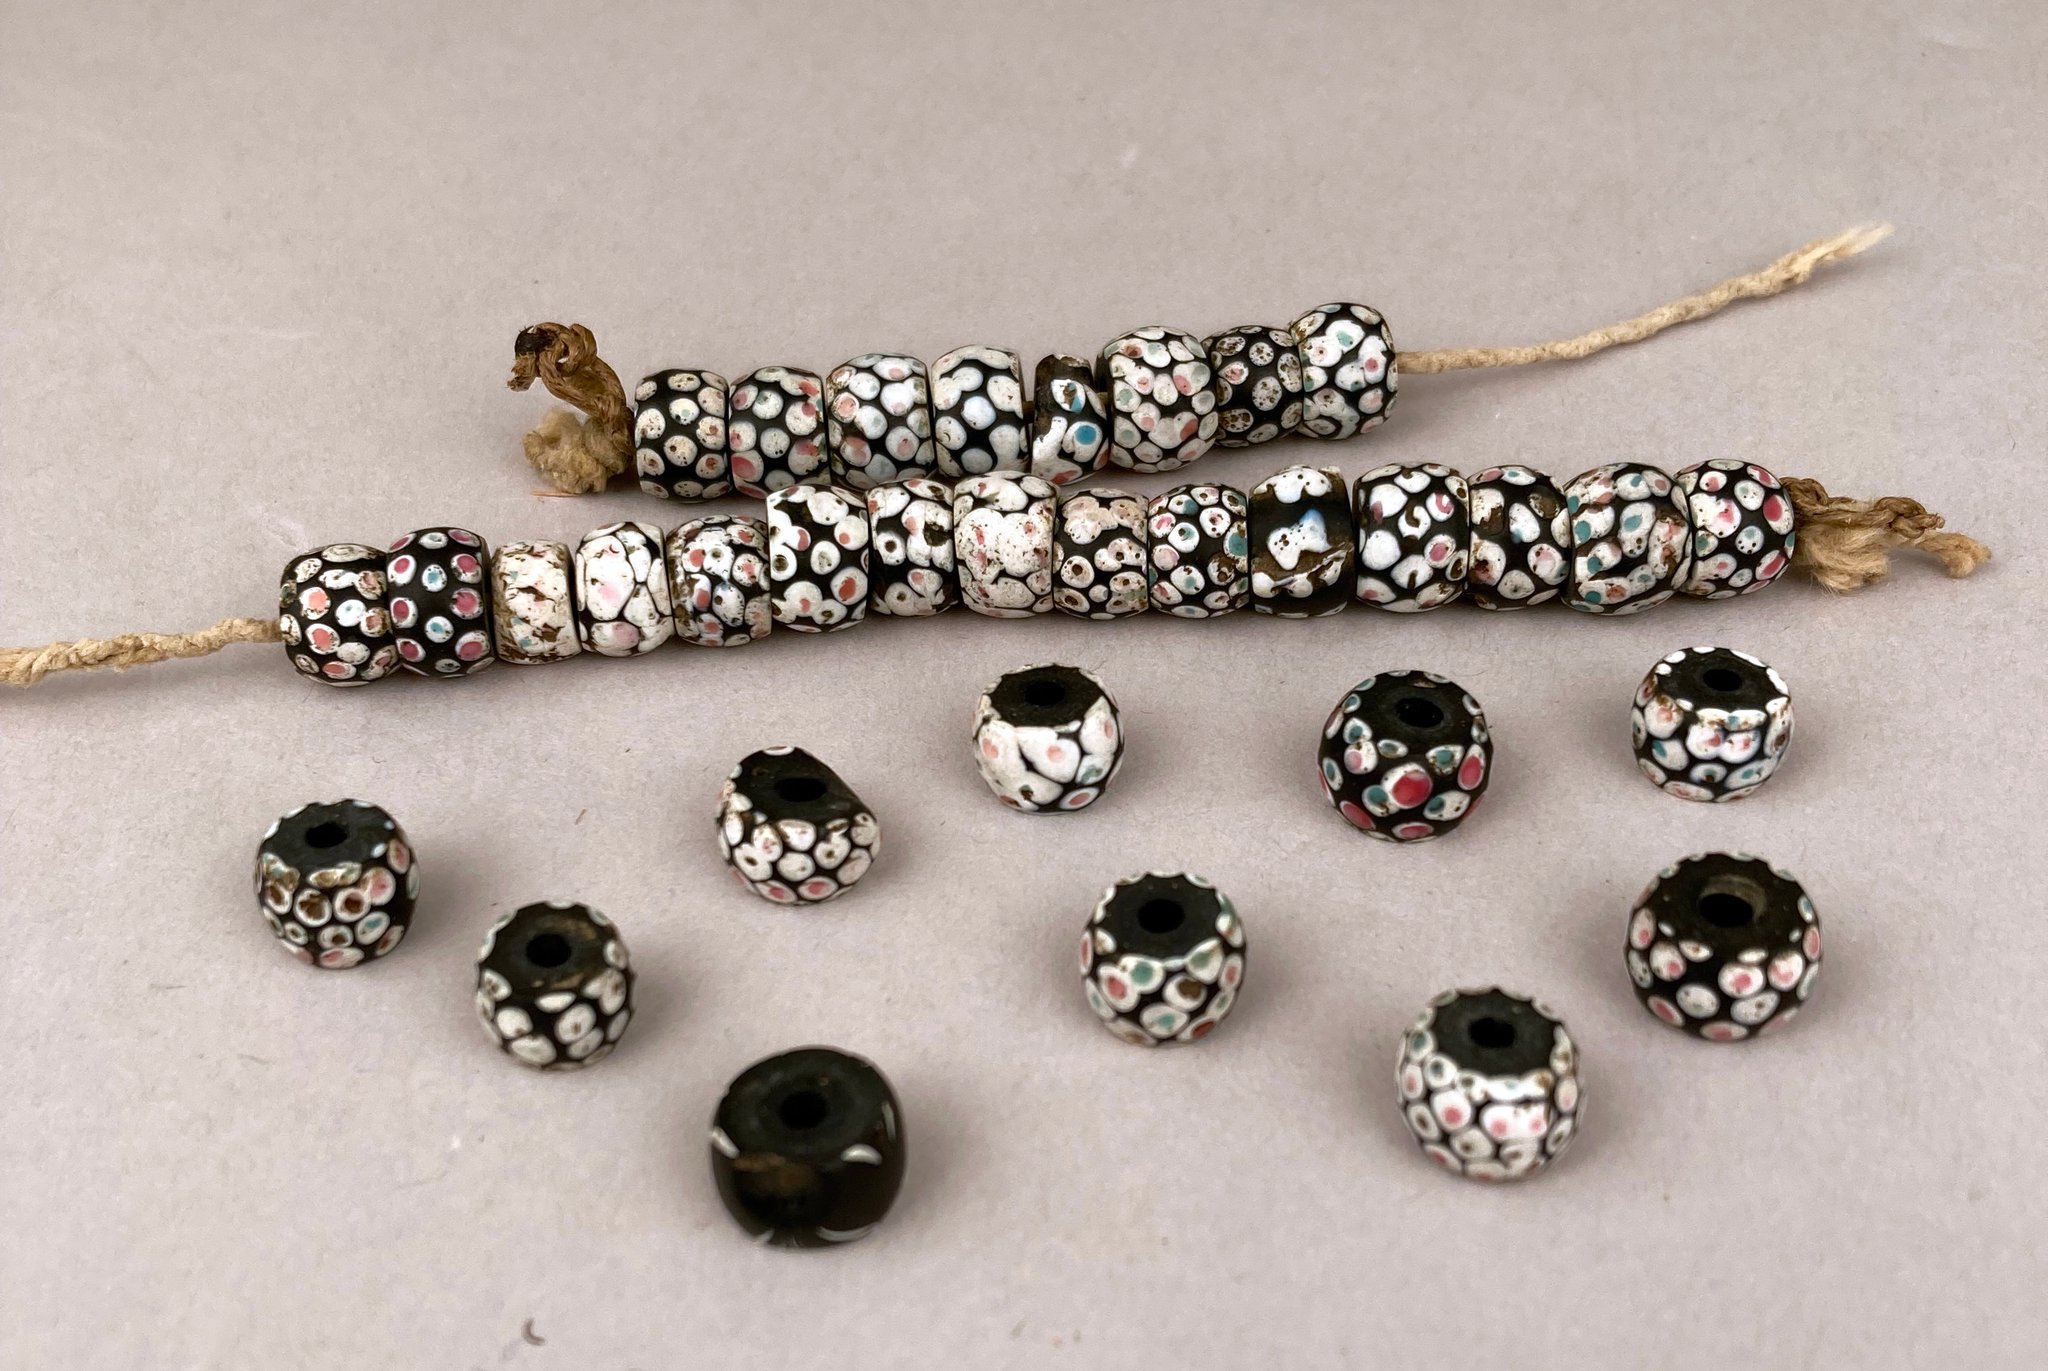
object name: bead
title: Beads (33)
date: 1701-1800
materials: glass